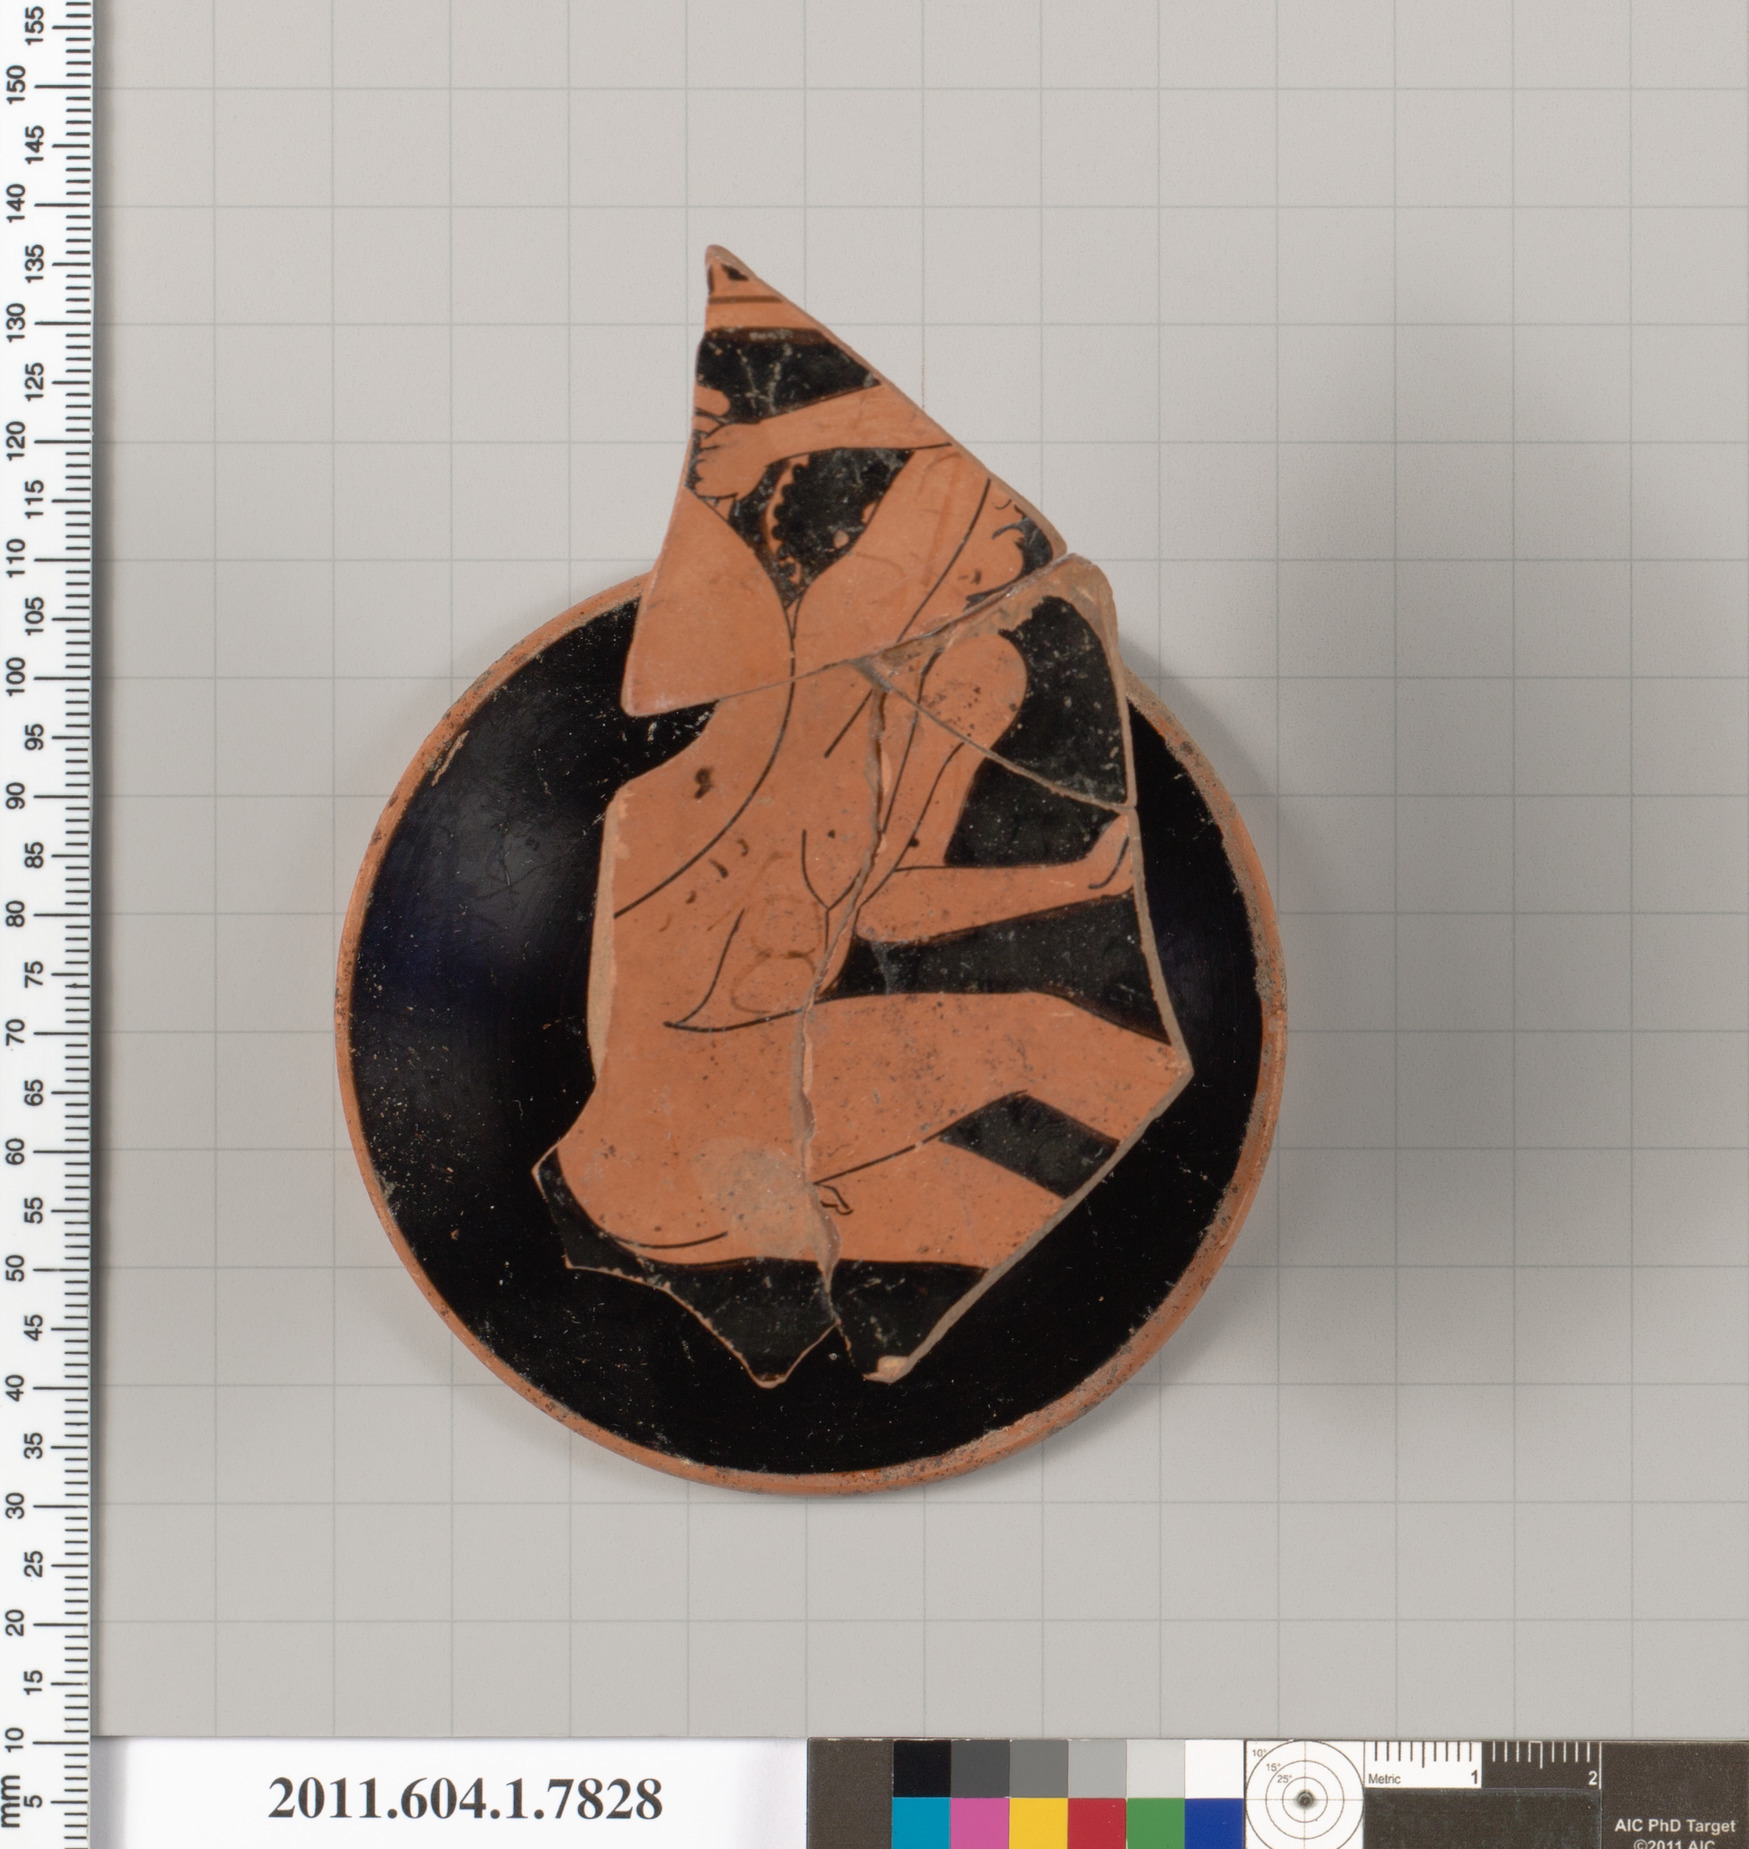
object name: kylix fragment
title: Terracotta fragment of a kylix (drinking cup)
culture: greek, attic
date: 475-451 BCE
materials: terracotta